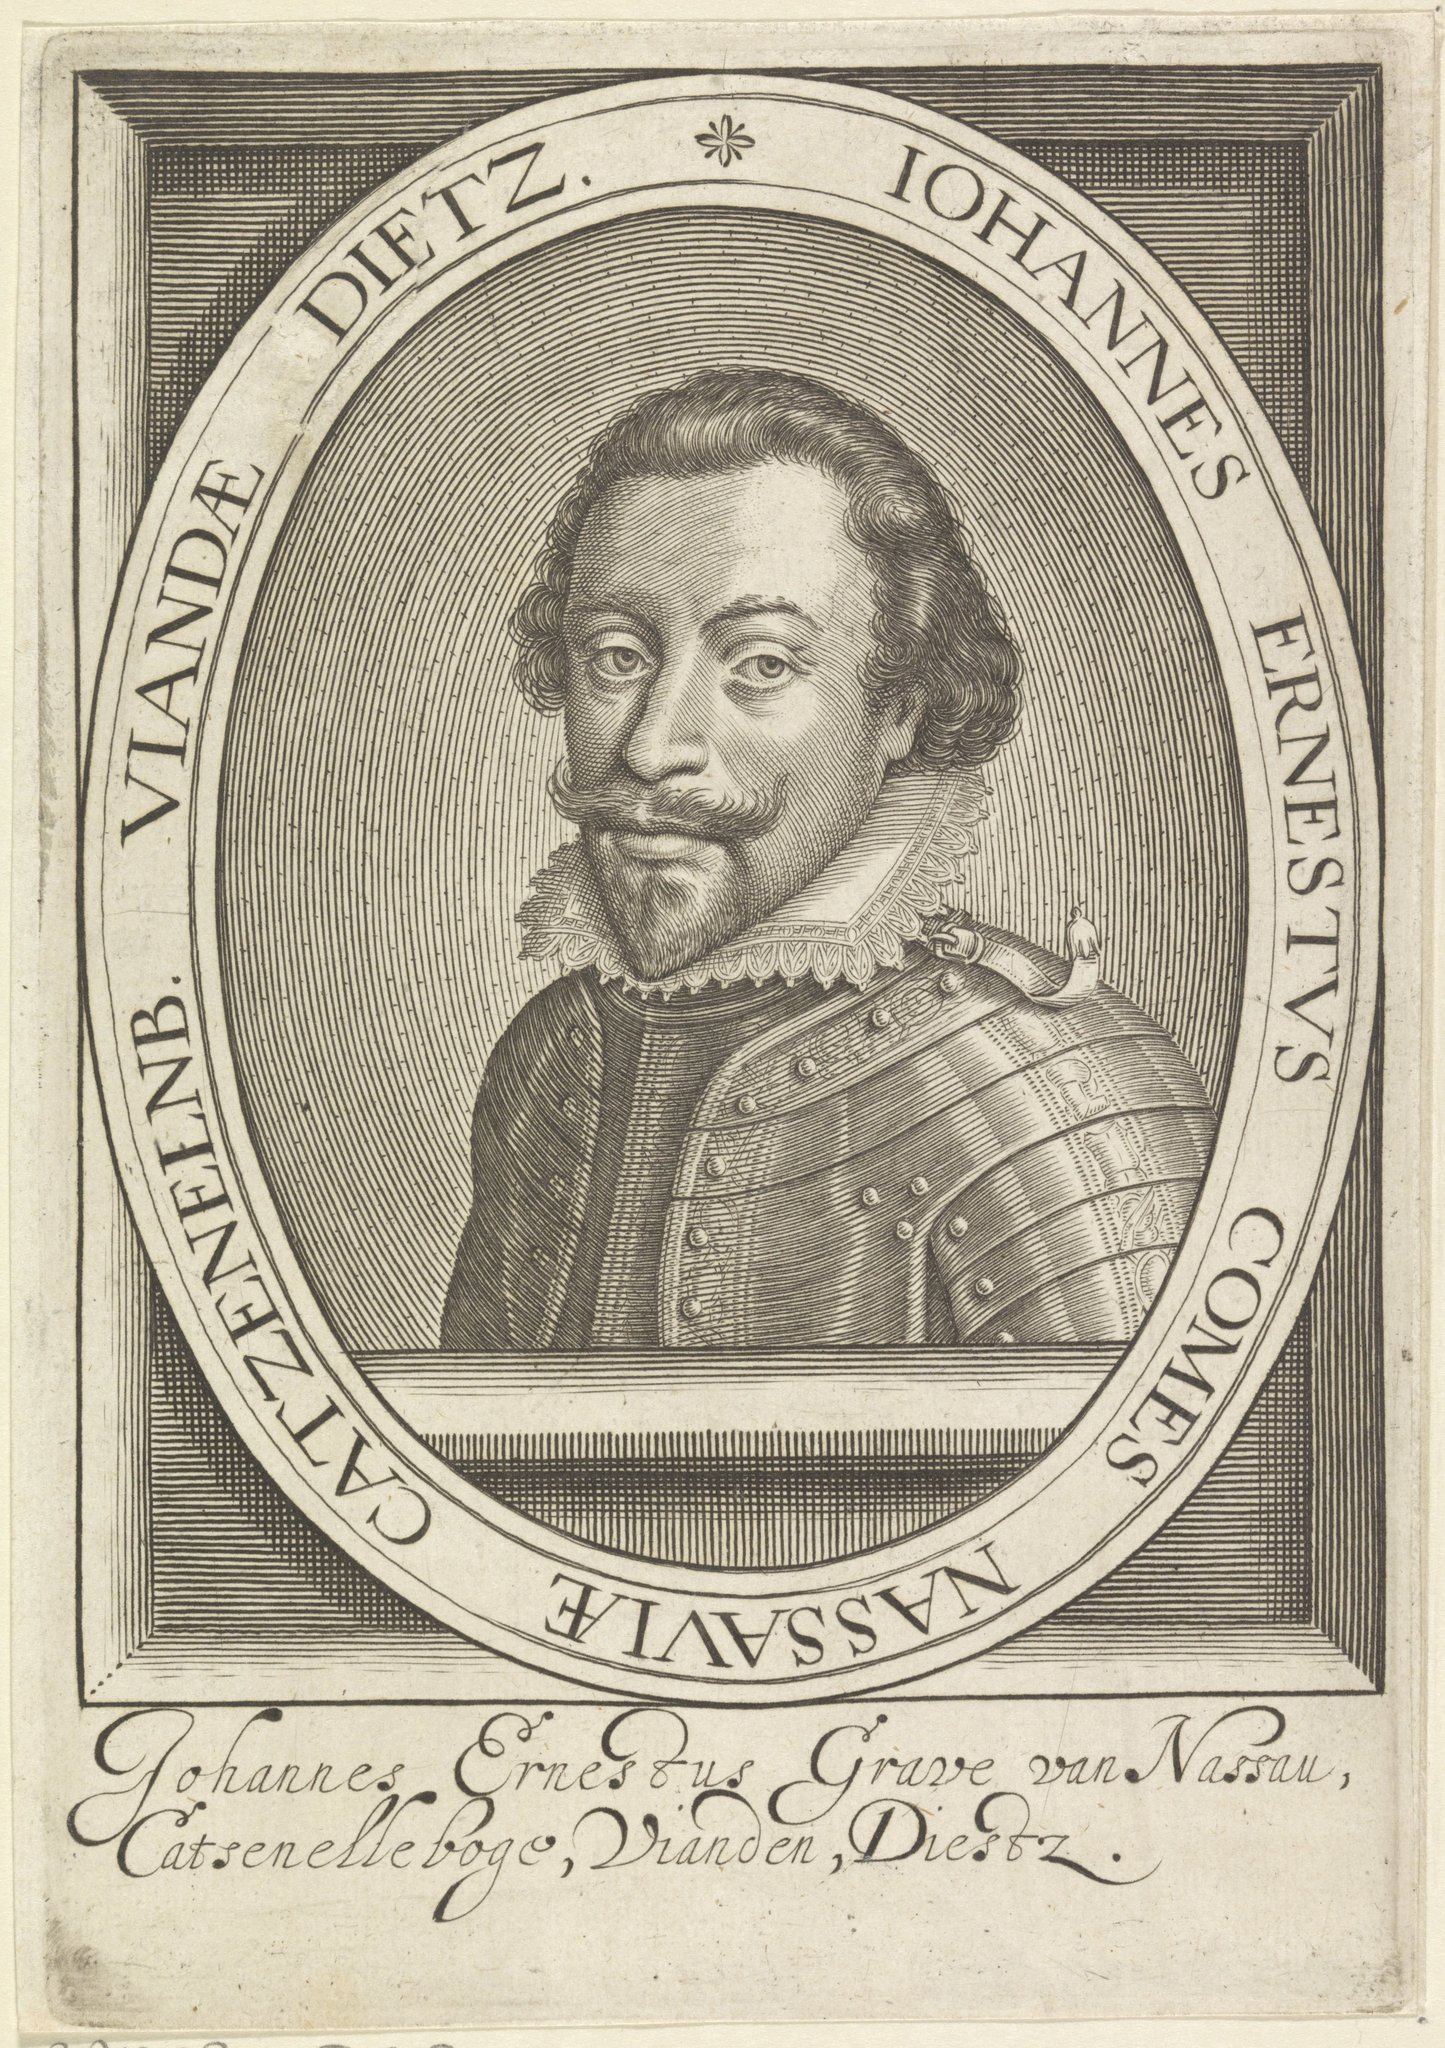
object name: print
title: Portret van Johan Ernst I, graaf van Nassau-Siegen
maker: Anonymous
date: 1600-1699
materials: paper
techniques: engraving, etching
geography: low countries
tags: johan ernst i graaf van nassau-siegen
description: De hier vermelde titel verwijst naar de hoogst verkregen titel van de geportretteerde, niet per se naar de titel die de geportretteerde op deze voorstelling draagt.